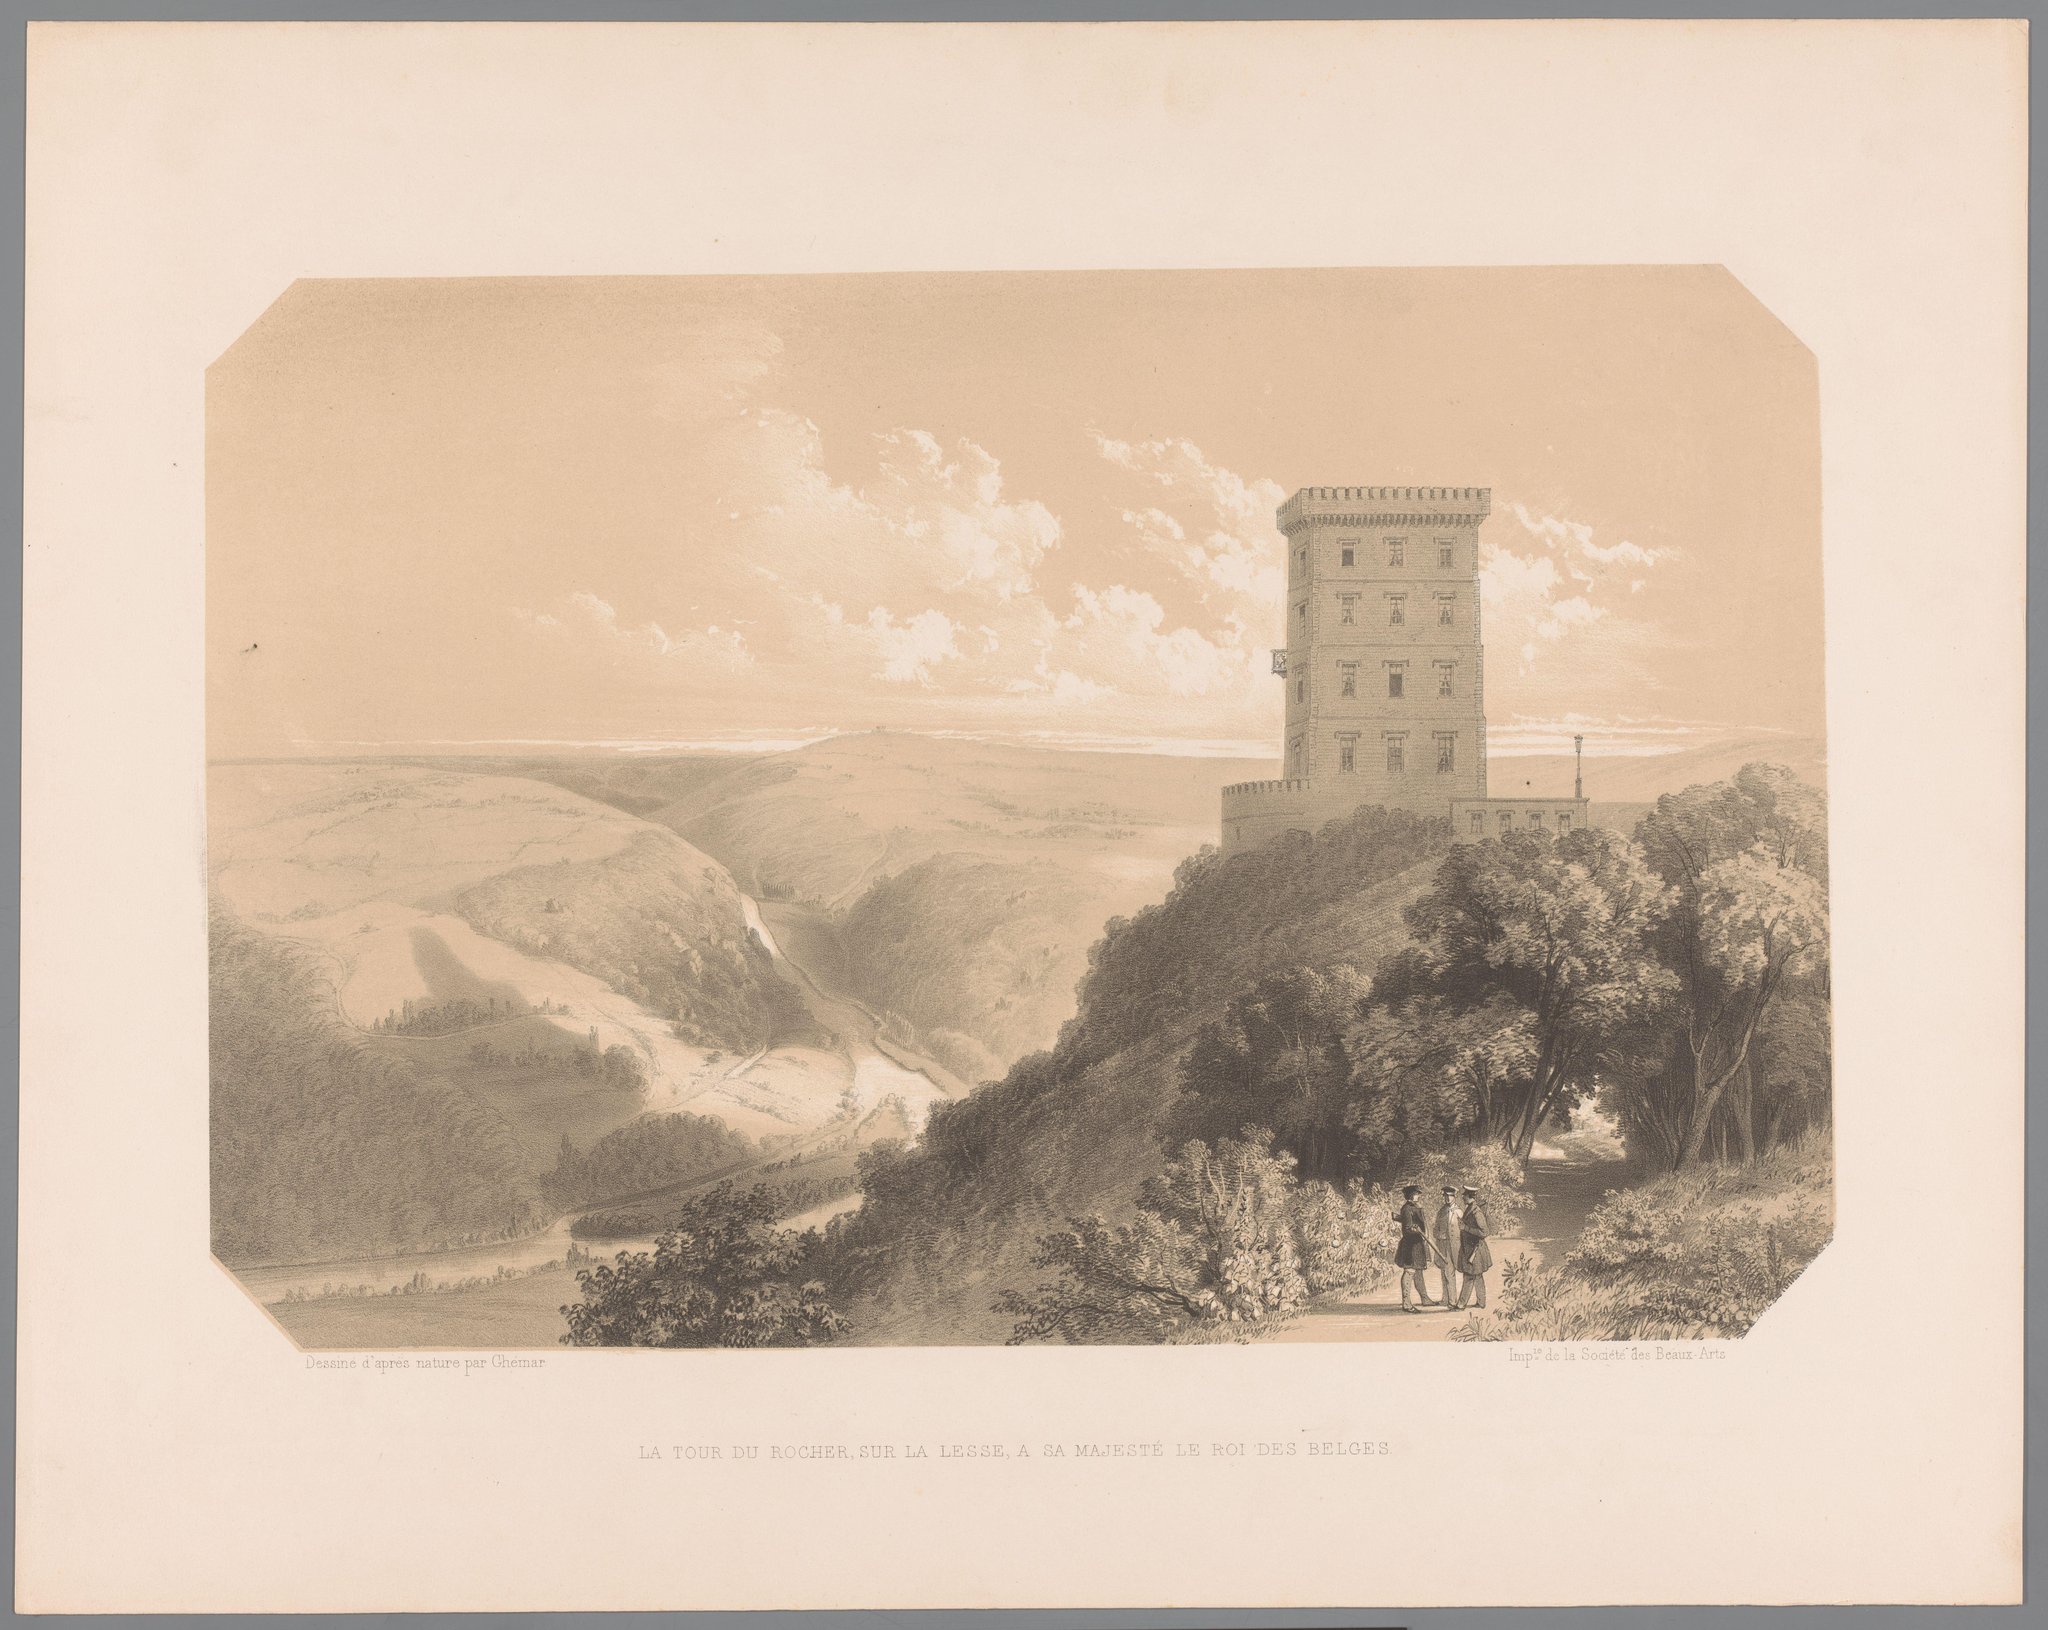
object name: print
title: Gezichten op het koninklijk bezit in de Ardennen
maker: louis ghémar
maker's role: draughtsman, print maker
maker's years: 1819-1873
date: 1846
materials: paper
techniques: tone lithography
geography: brussels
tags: river, (high) hill, landscape with tower or castle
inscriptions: collector's mark: Lugt 2228